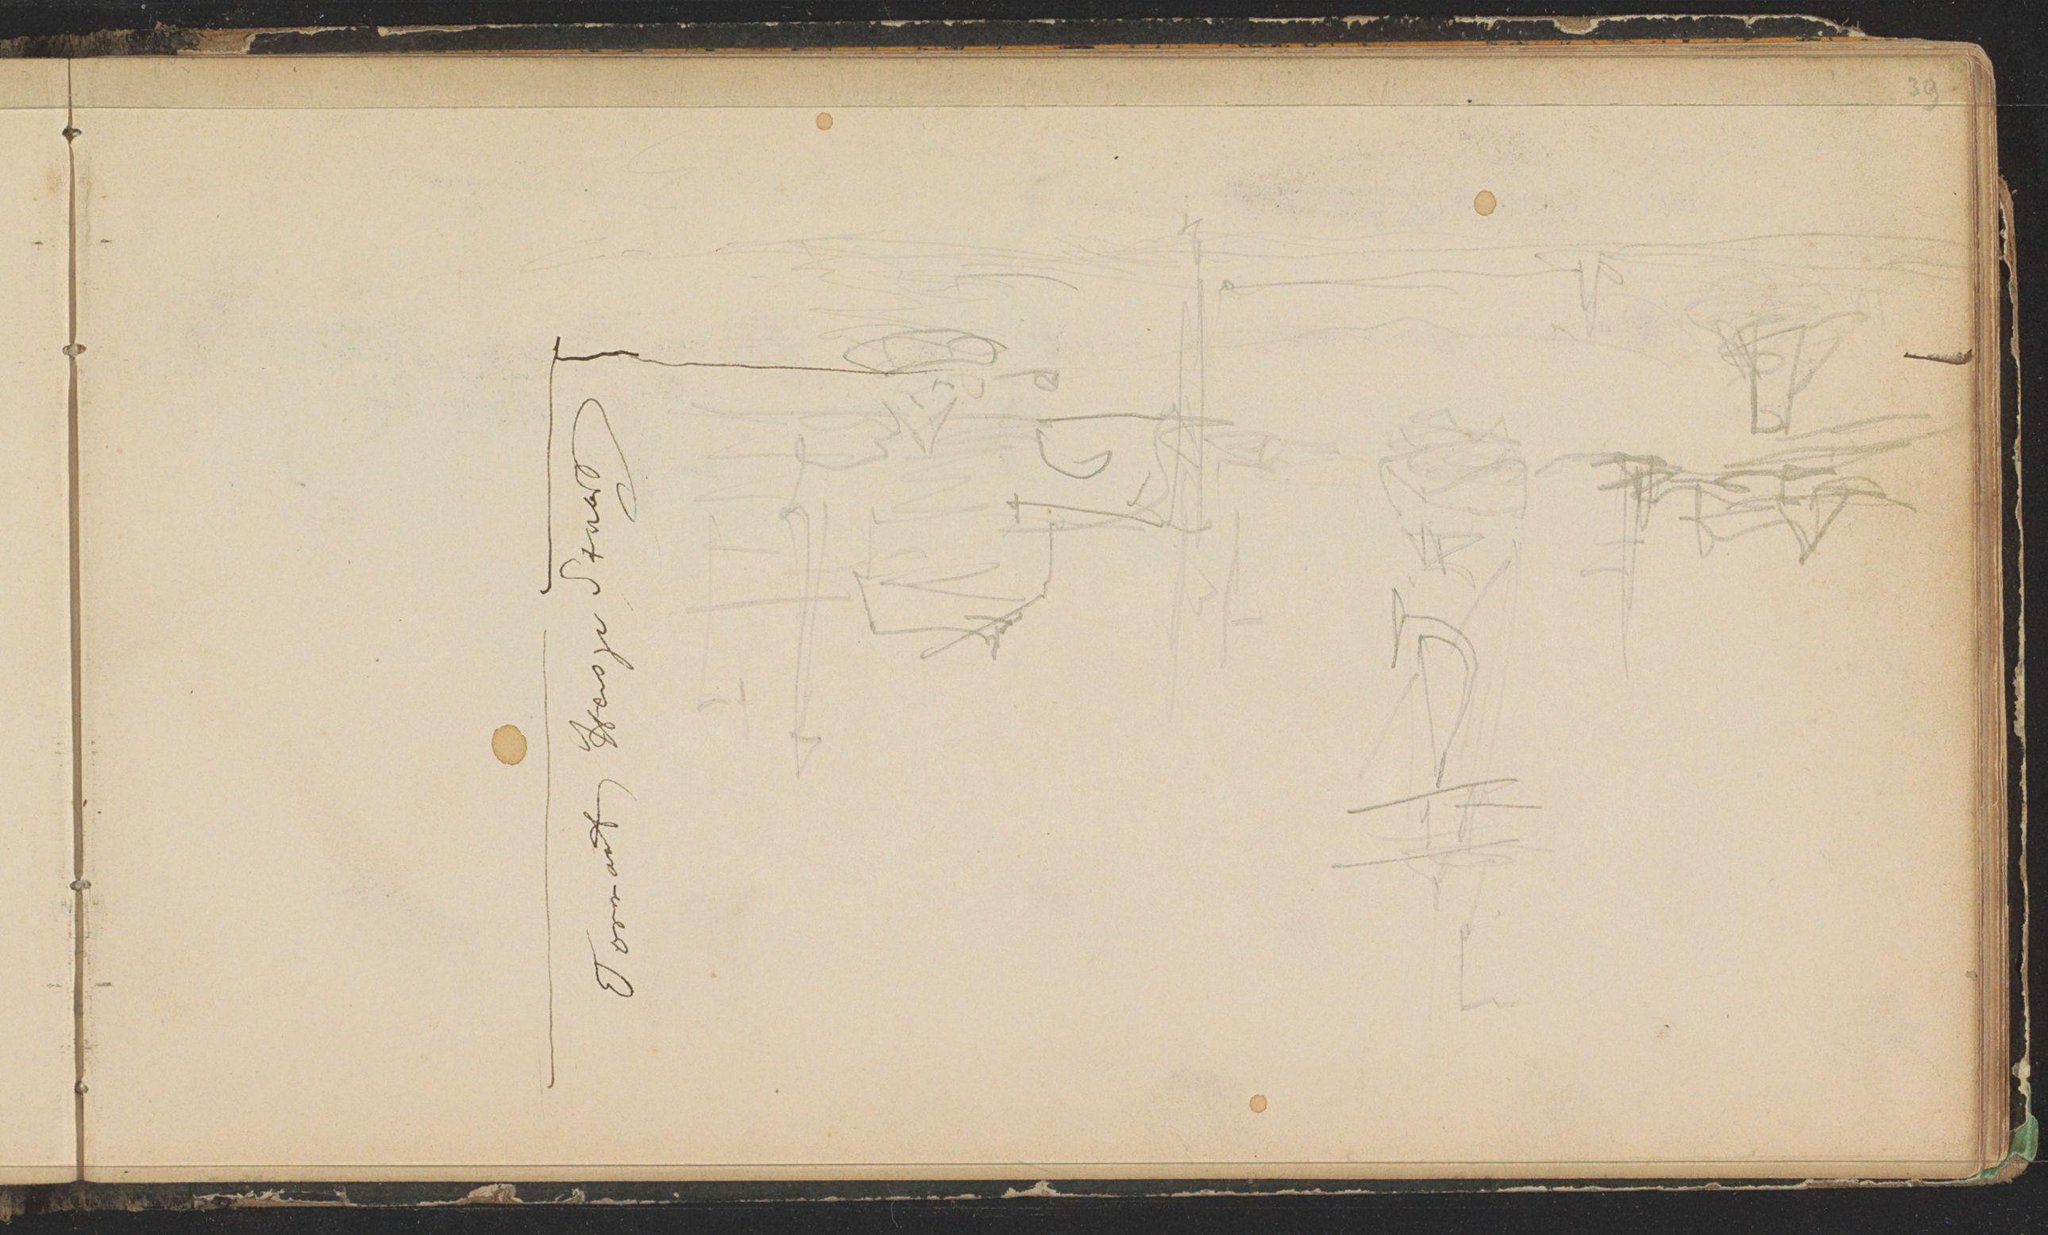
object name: sketchbook leaf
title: Zeilschepen en -boten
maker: johannes bosboom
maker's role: draughtsman, painter, print maker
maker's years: 1817-1891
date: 1845-1891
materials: paper, pencil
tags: sailing-ship, sailing-boat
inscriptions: annotation: ‘Tomaat kasje stua[..]’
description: Blad 39 recto uit een schetsboek met 46 bladen.